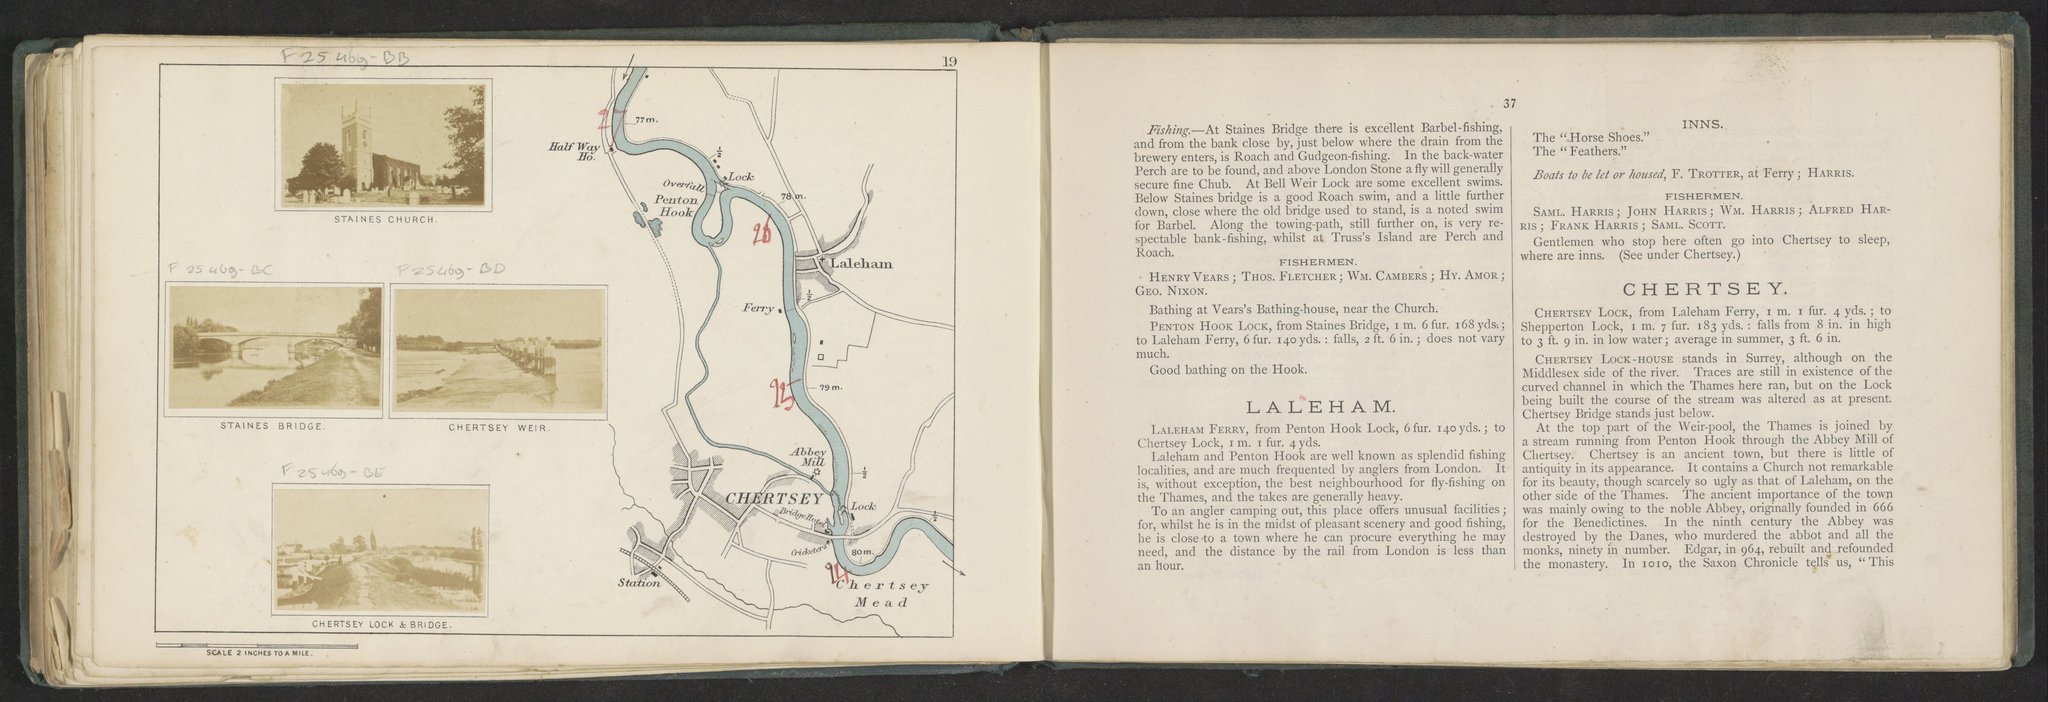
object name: page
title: Gezicht op een waterkering in de Theems bij Chertsey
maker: henry w. taunt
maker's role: fotograaf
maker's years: 1842-1922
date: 1871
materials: photographic support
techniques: albumen print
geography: chertsey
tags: sluice, weir, river, thames